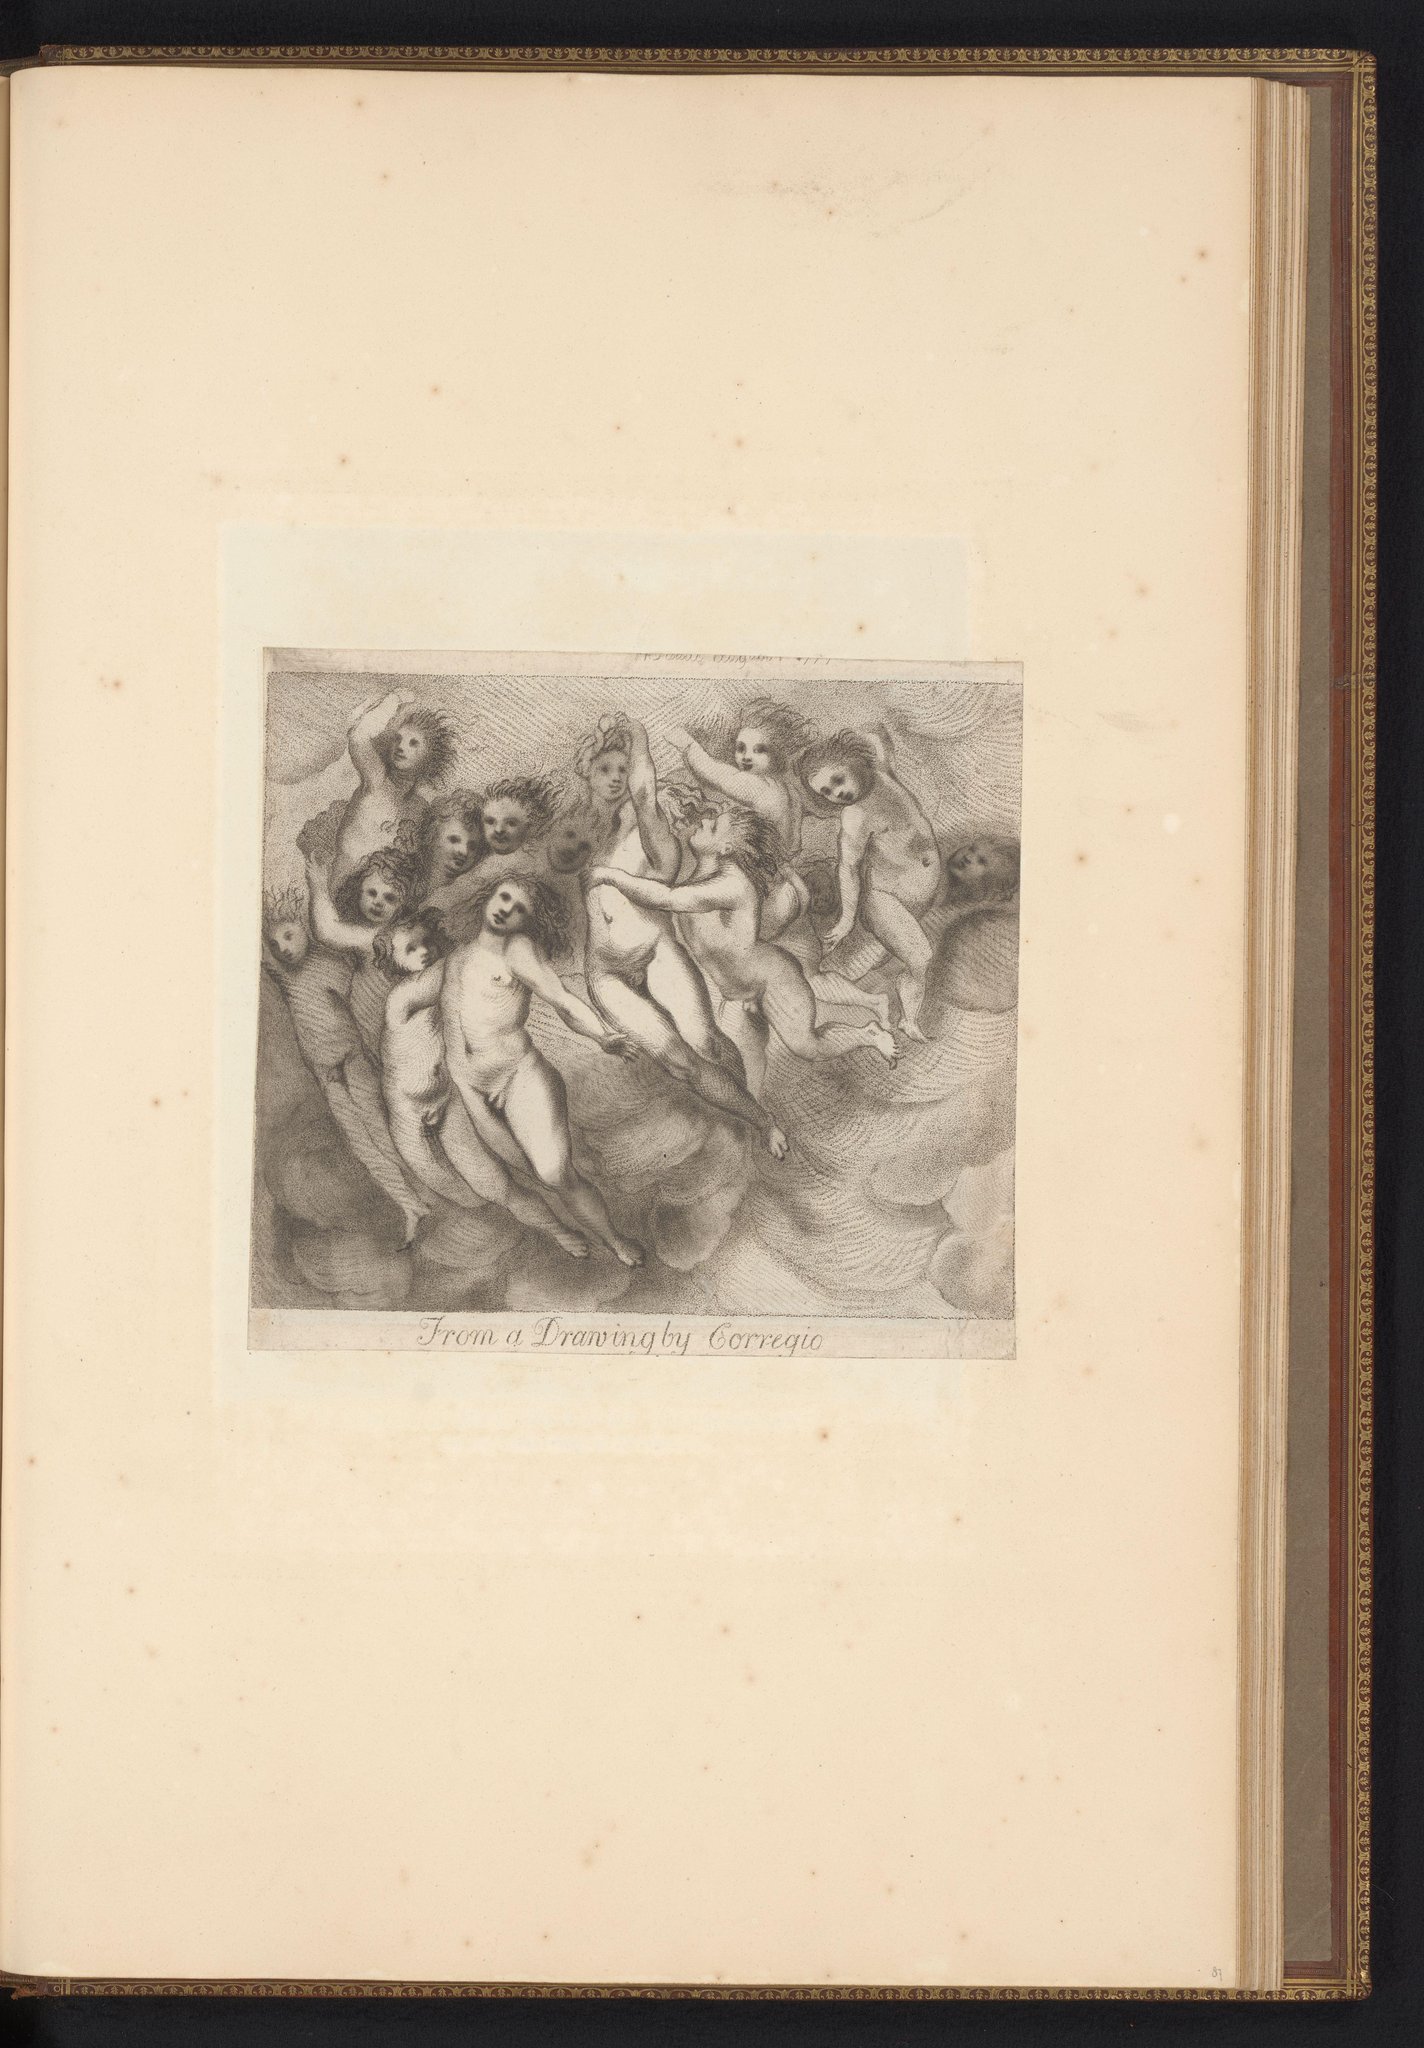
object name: album leaf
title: Engelen in glorie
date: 1777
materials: paper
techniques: printmaking, etching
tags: the (nude) human figure; 'corpo humano' (ripa), angels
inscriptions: inscription: ‘Pisces, One of the Signs in the Zodiac. ... William Hogarth sculpsit, circa annum 1730 ... Printed for John and Josiah Boydell.’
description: Engelen of naakte figuren zwevend tussen de wolken. De prent maakt deel uit van een album.